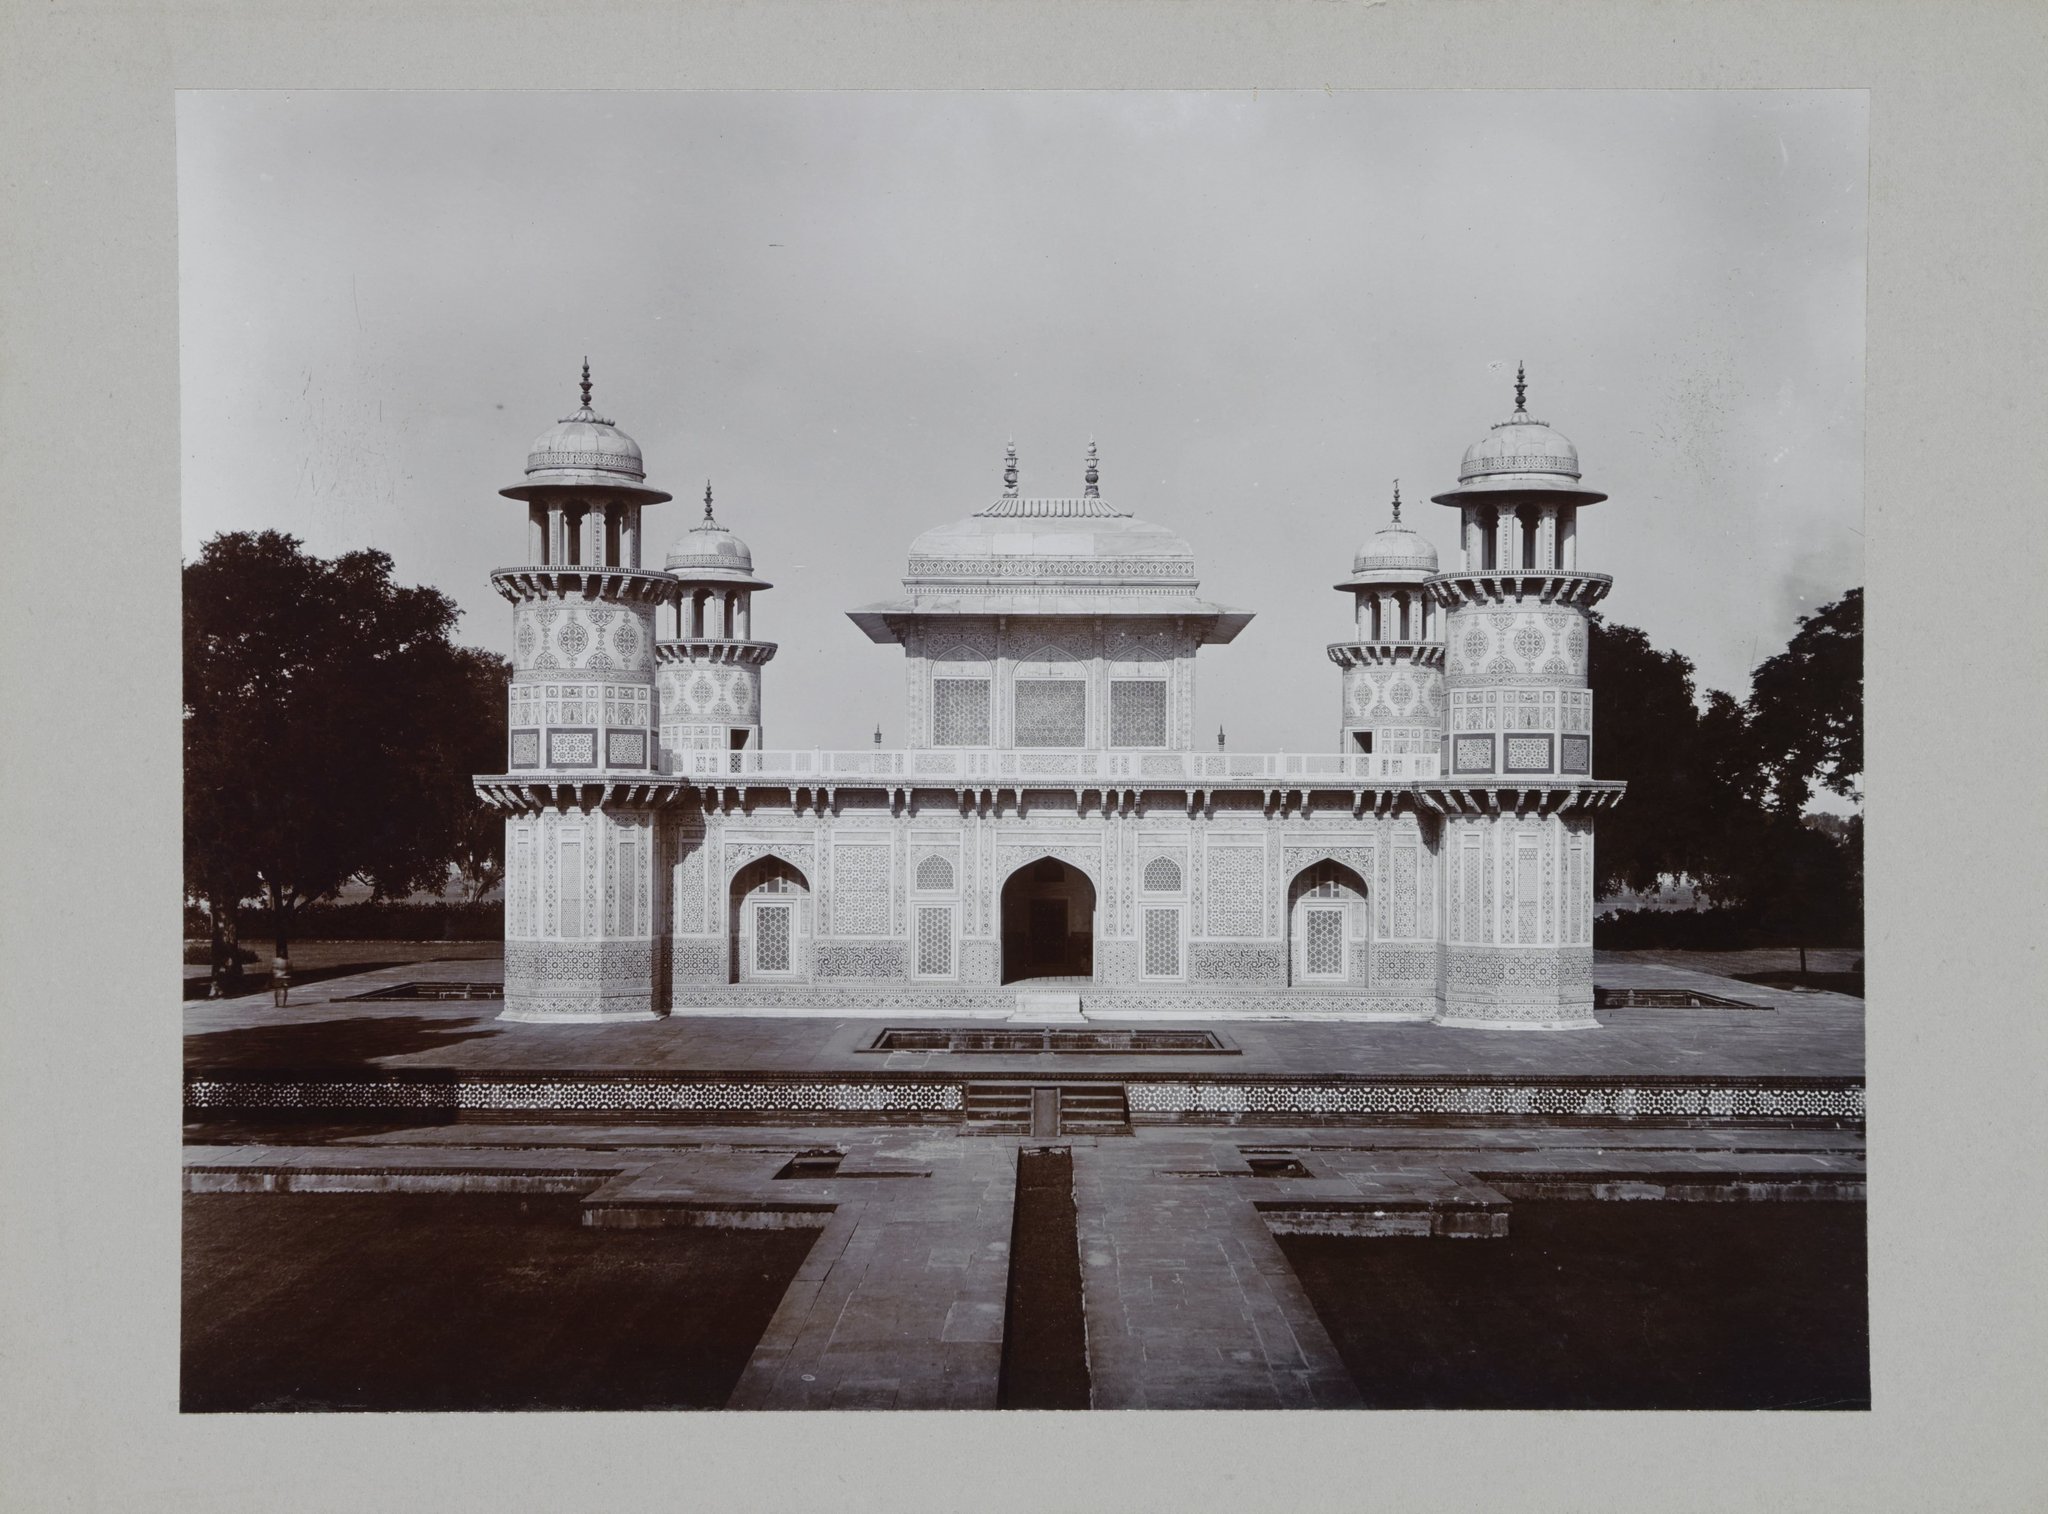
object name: photograph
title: Tomb of Itimad ud-Daulah, Agra, Uttar Pradesh, India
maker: Anonymous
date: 1895-1915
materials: cardboard, paper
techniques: gelatin silver print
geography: agra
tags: agra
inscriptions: annotation: ‘52. Mausoleum van I'timad bij Agra.’